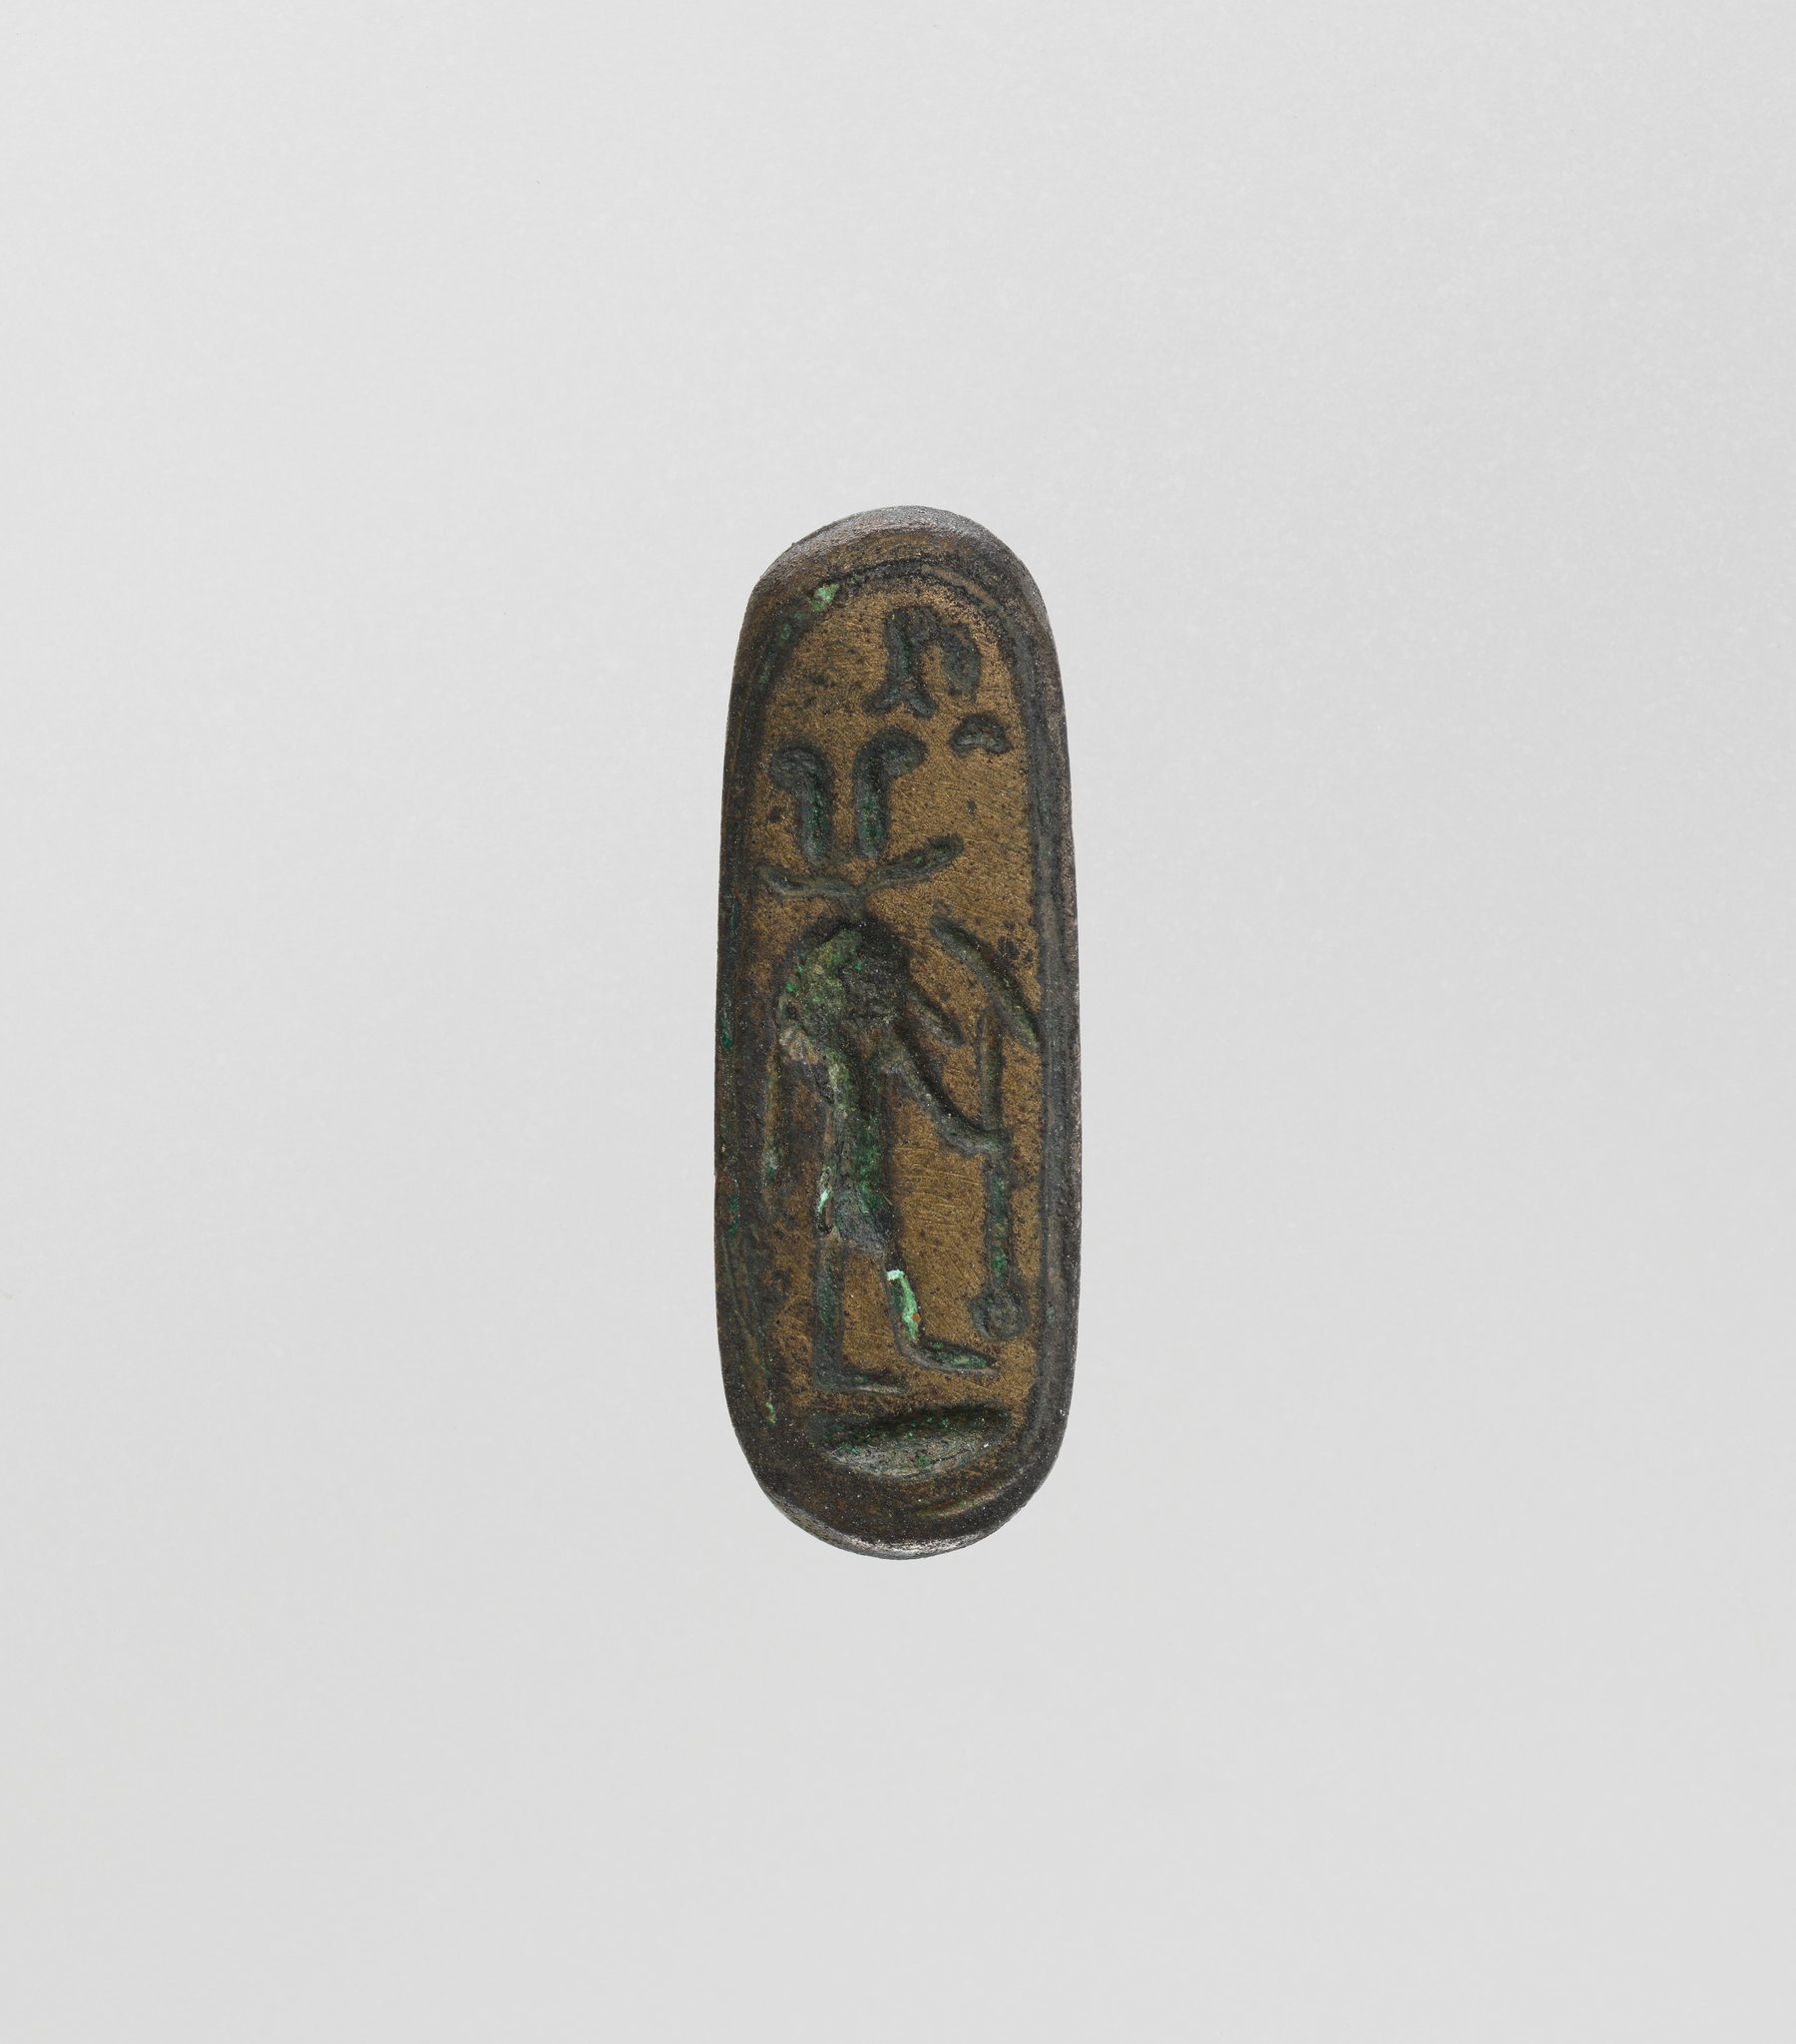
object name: ring, signet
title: Signet ring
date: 1070-712 BCE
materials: faience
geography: egypt